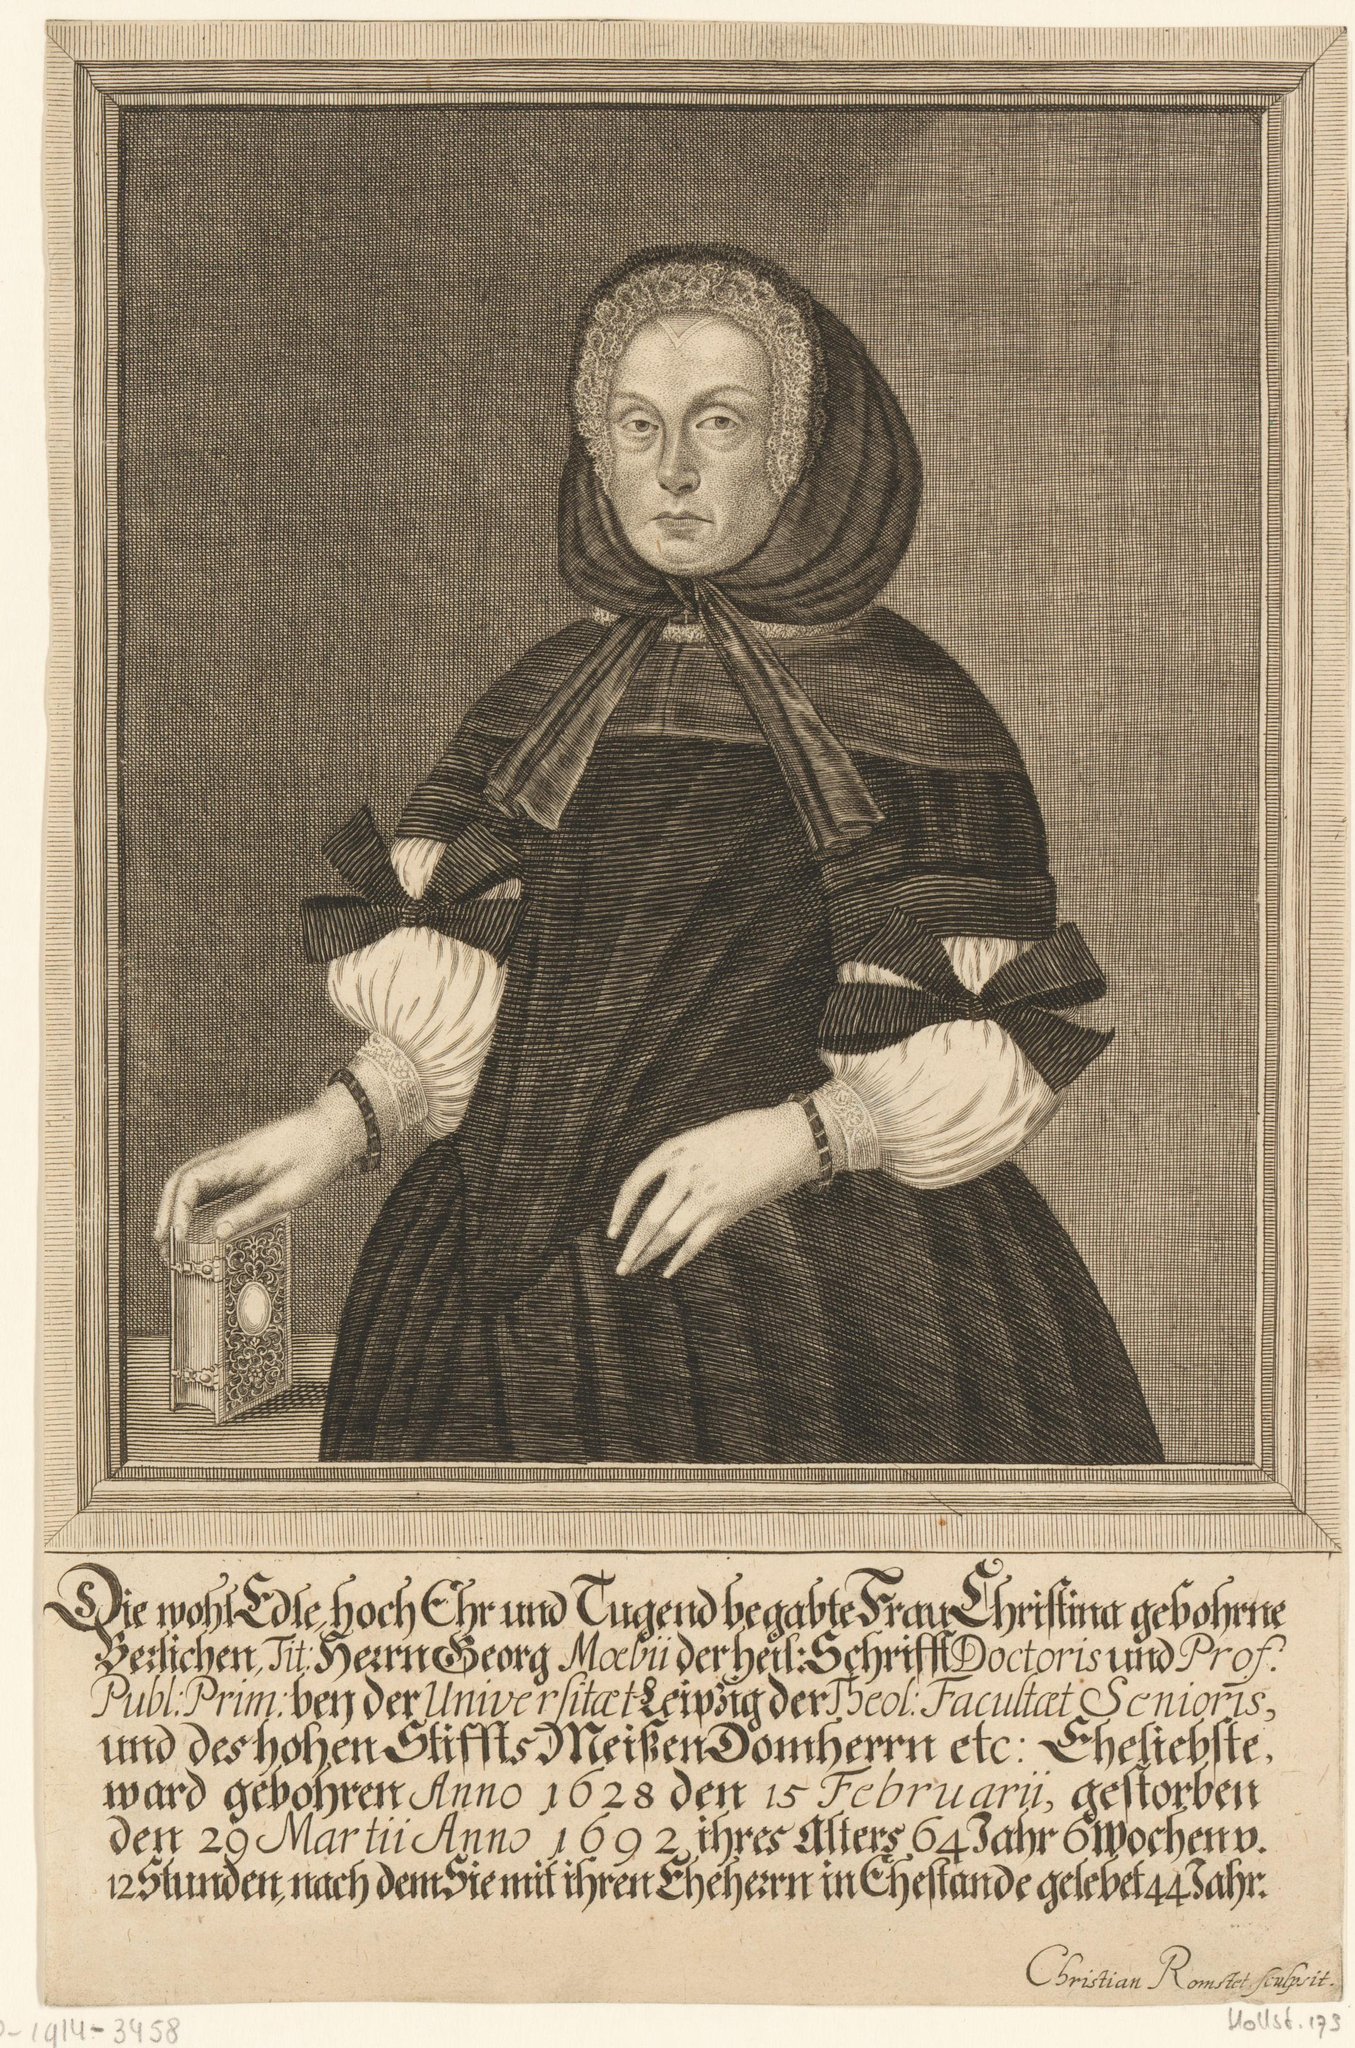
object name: print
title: Portret van Christina Moebius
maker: christian romstet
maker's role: print maker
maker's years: 1640-1721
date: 1692-1721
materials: paper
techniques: engraving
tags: historical persons - bb - woman, book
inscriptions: collector's mark: Lugt 2228